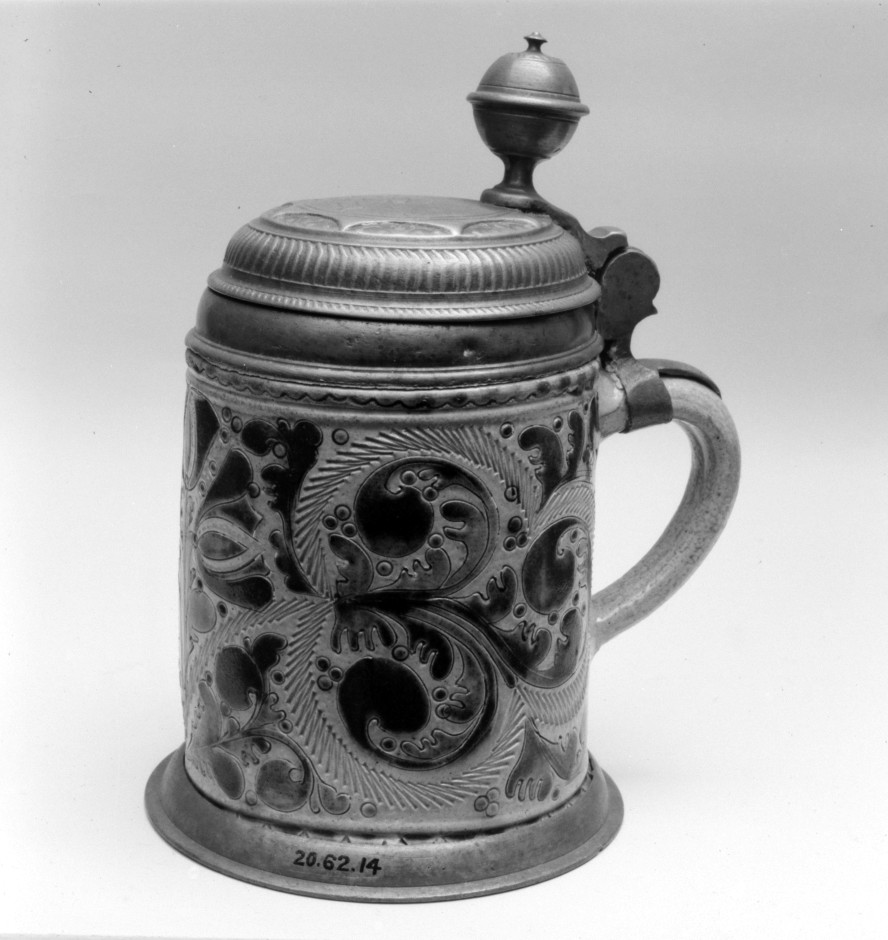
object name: tankard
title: Tankard (Stein)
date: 1701-1800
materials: pewter, stoneware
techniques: salt glaze